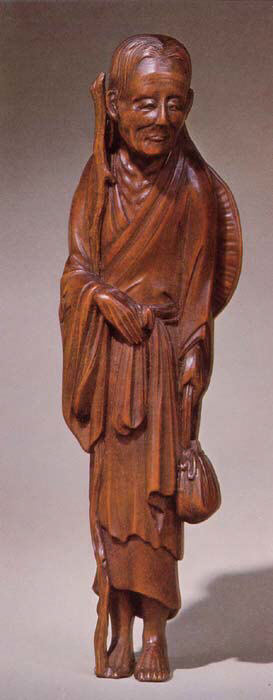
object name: netsuke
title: Netsuke of Ono no Komachi (834–900)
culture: japanese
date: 1867-1900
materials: wood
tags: women